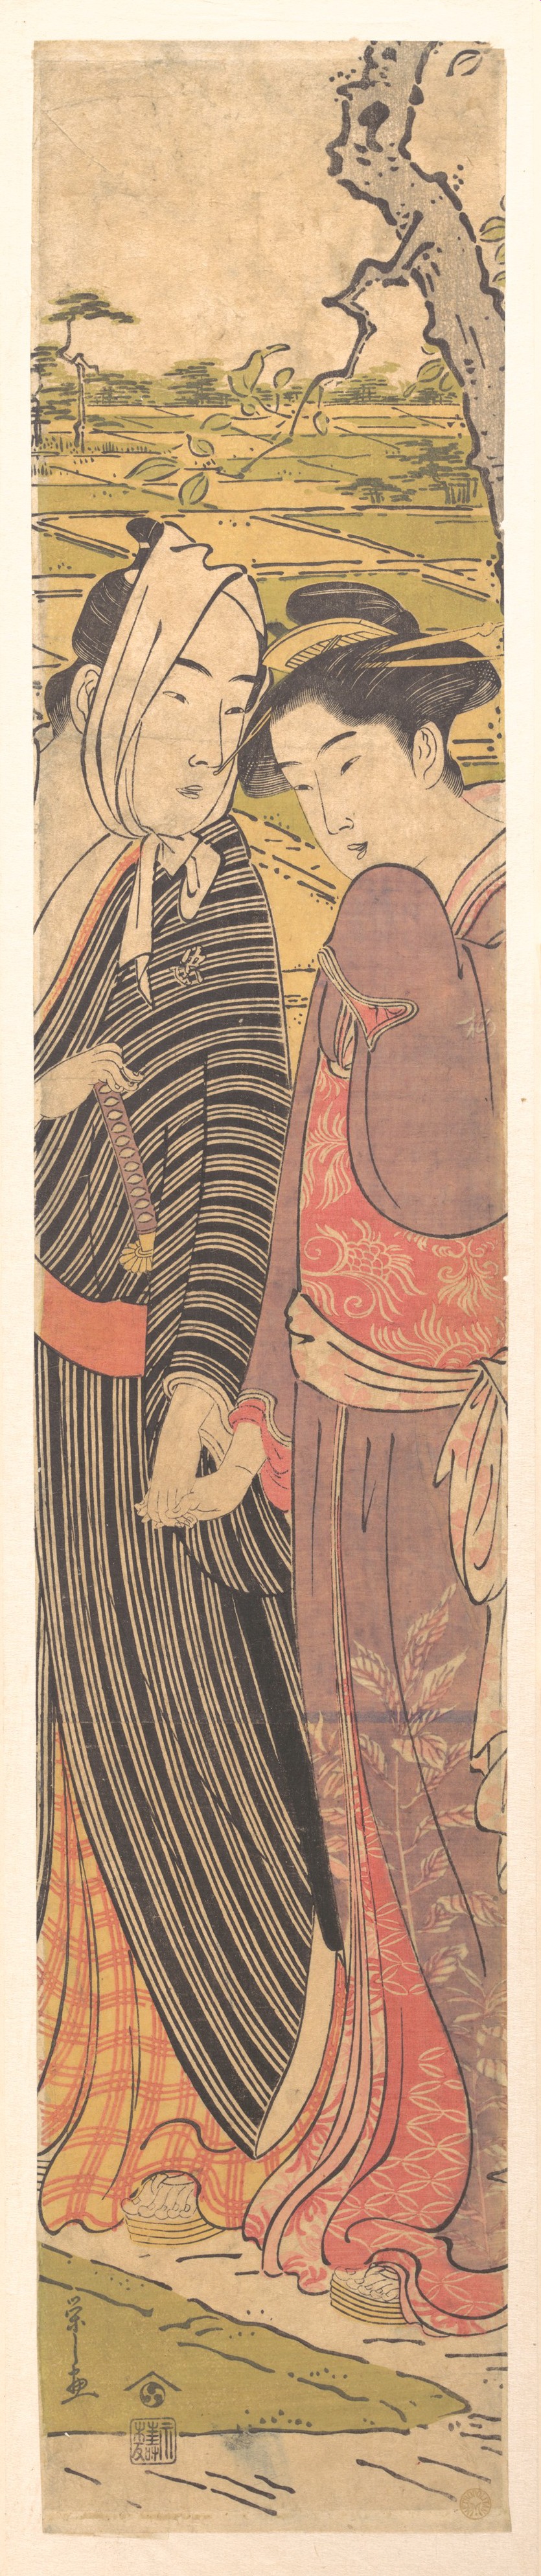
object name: print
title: A Man and a Girl Walking in the Rice Fields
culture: japanese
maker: chōbunsai eishi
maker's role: artist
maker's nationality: japanese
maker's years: 1756-1829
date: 1780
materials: ink, paper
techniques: woodblock print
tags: girls,men